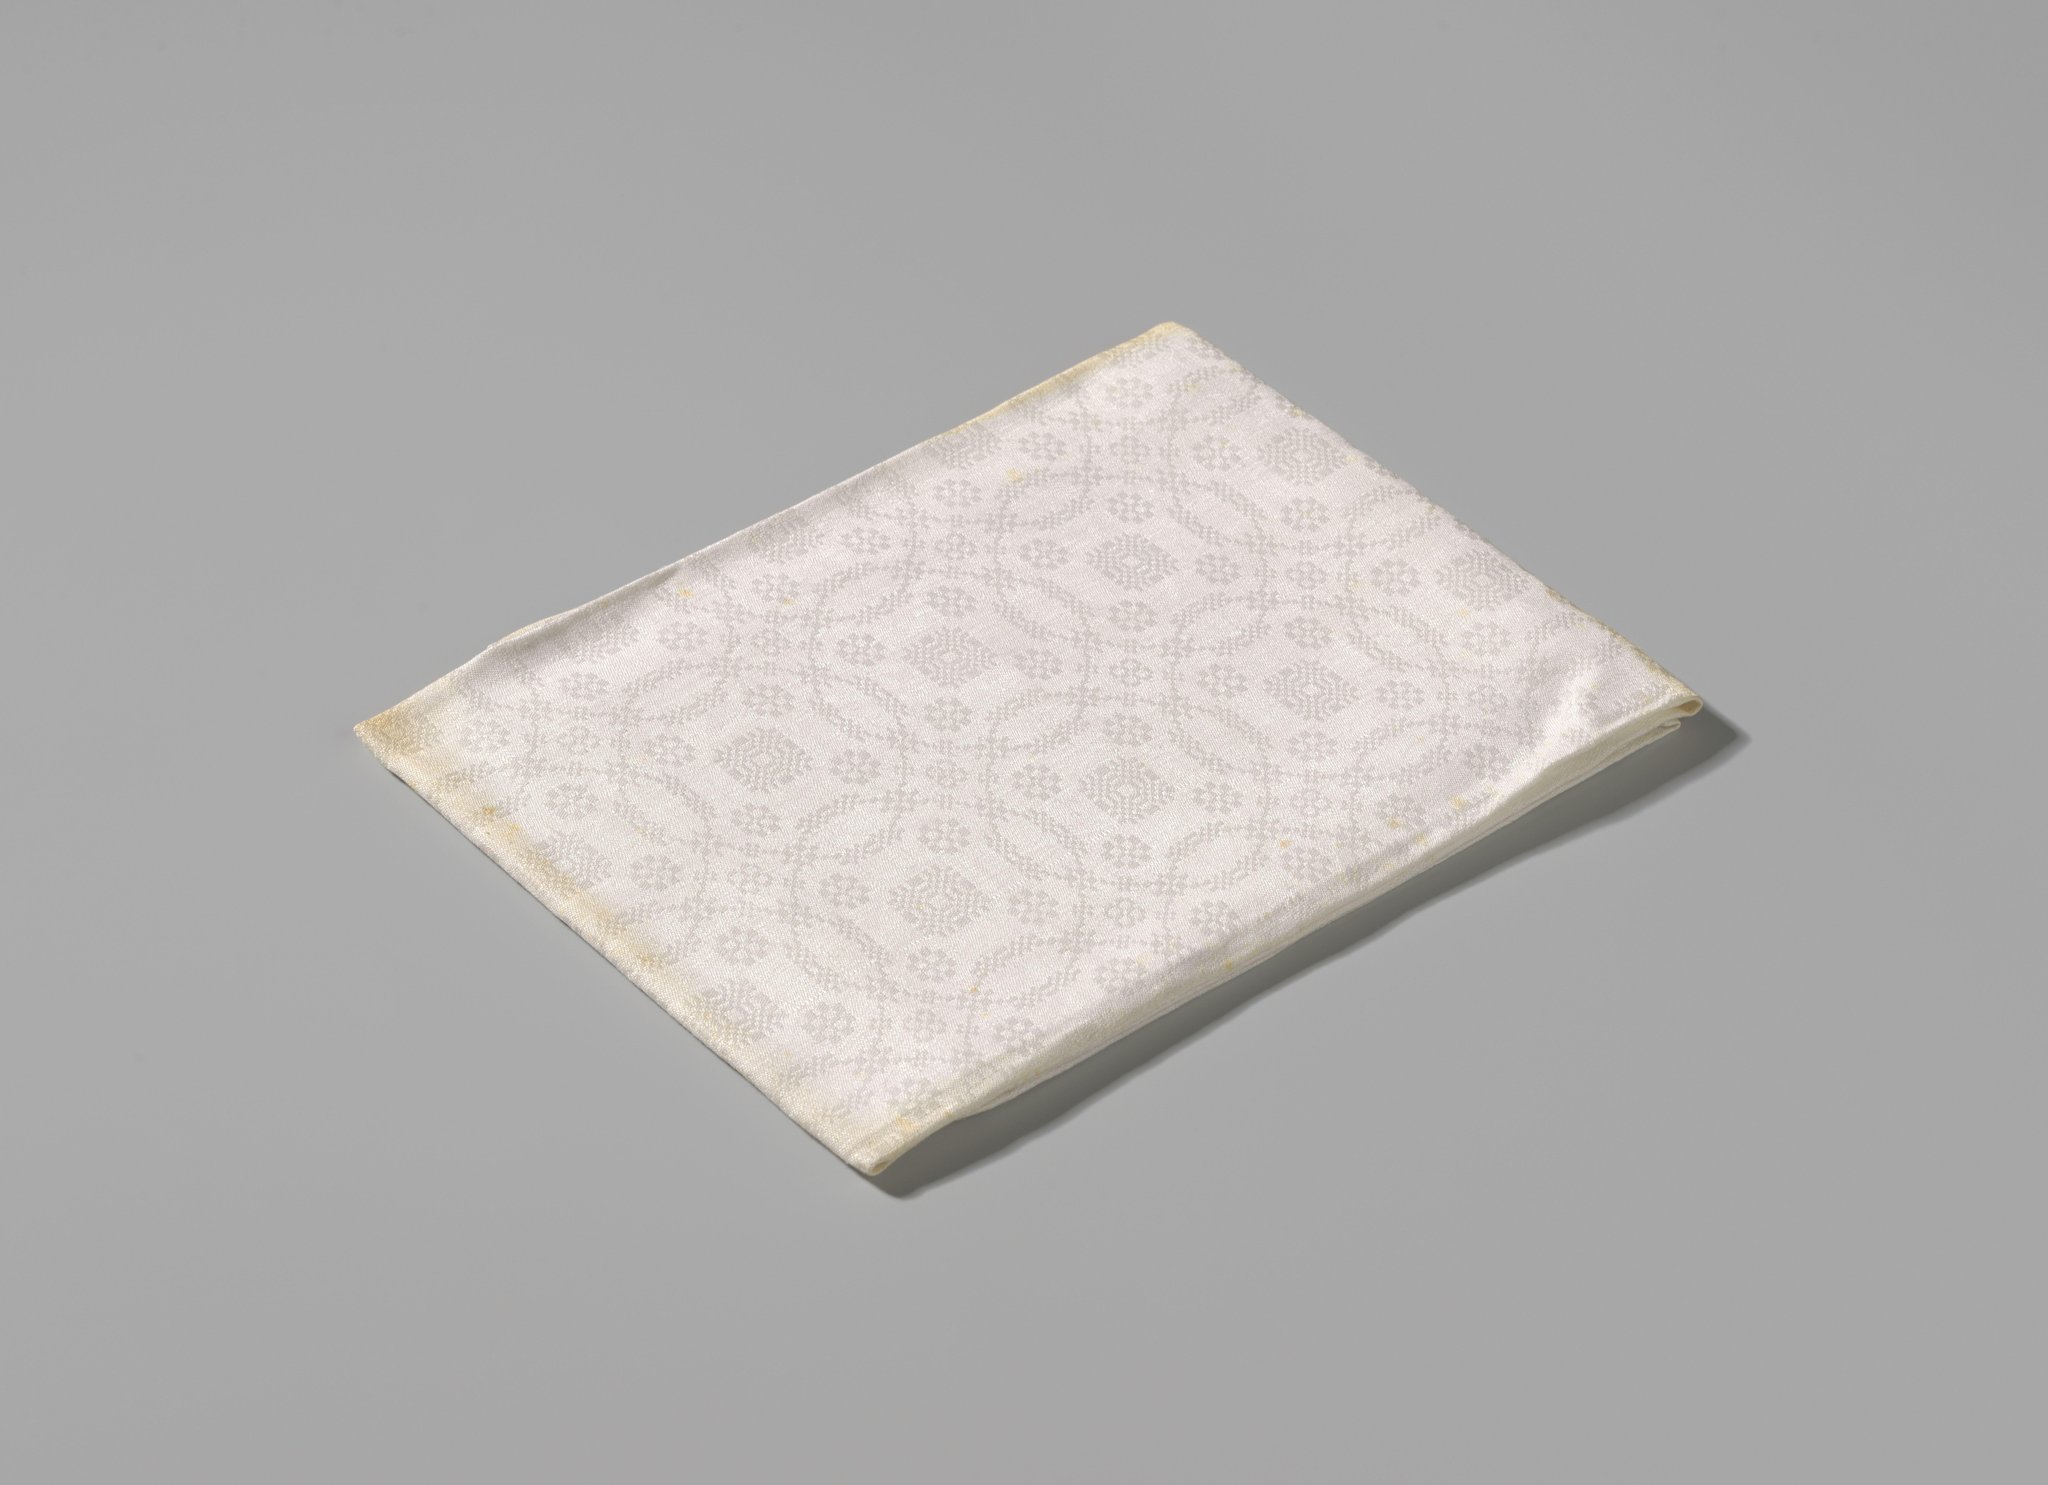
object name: napkin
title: Servet van pellendamast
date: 1675-1700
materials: linen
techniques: weave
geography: netherlands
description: Servet van pellendamast. Het servet is gemerkt: KS. Bij het servet hoort een servet met invnr. BK-1980-112-B.